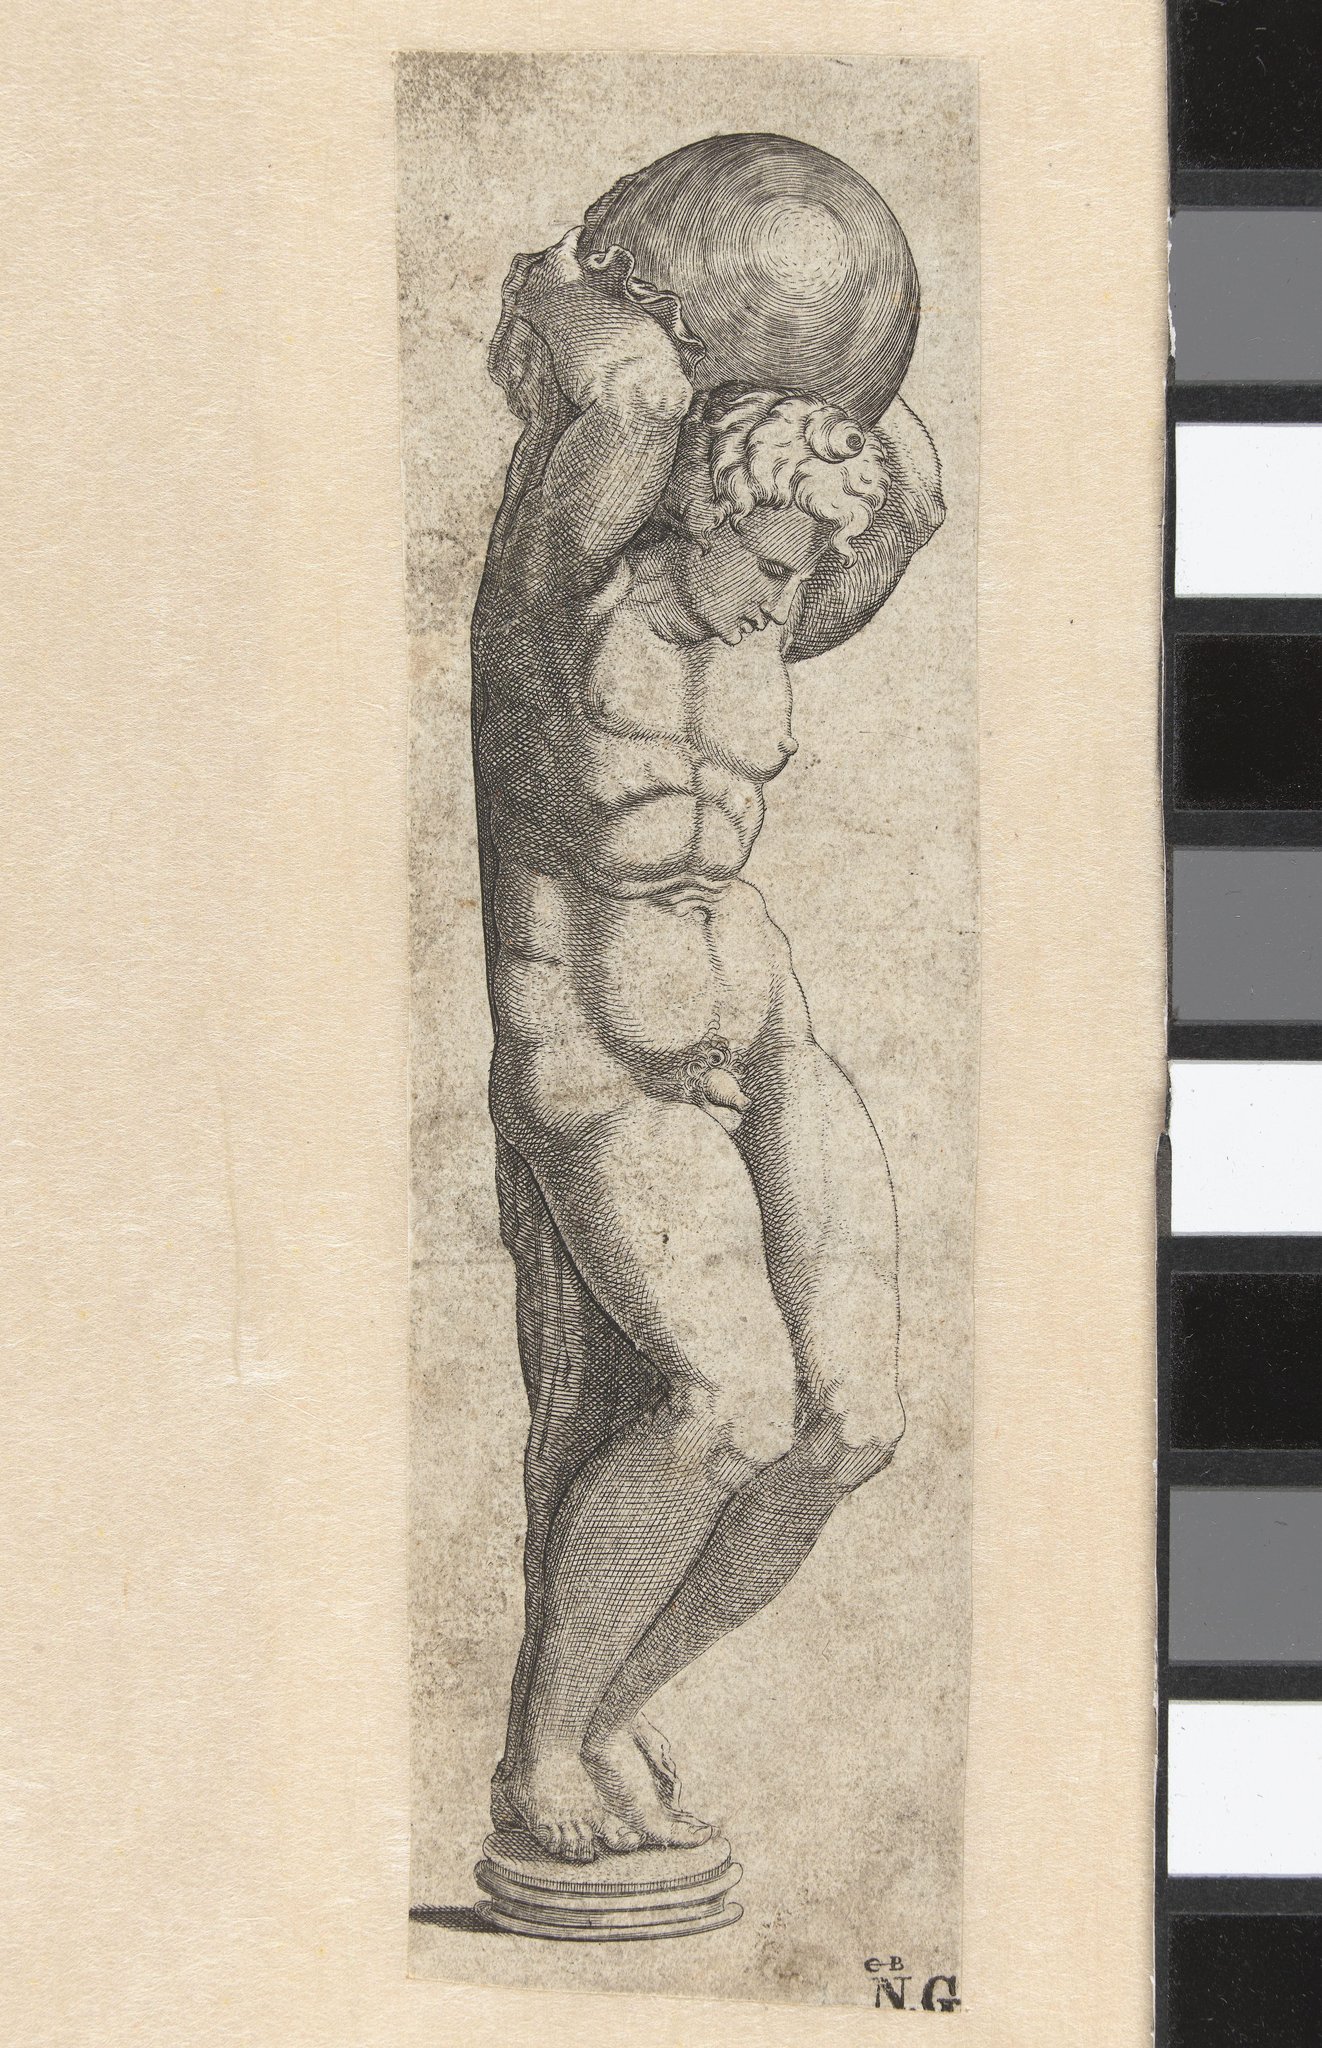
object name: print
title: Sculptuur. Atlas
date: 1535-1540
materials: paper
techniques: engraving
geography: netherlands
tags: (story of) atlas